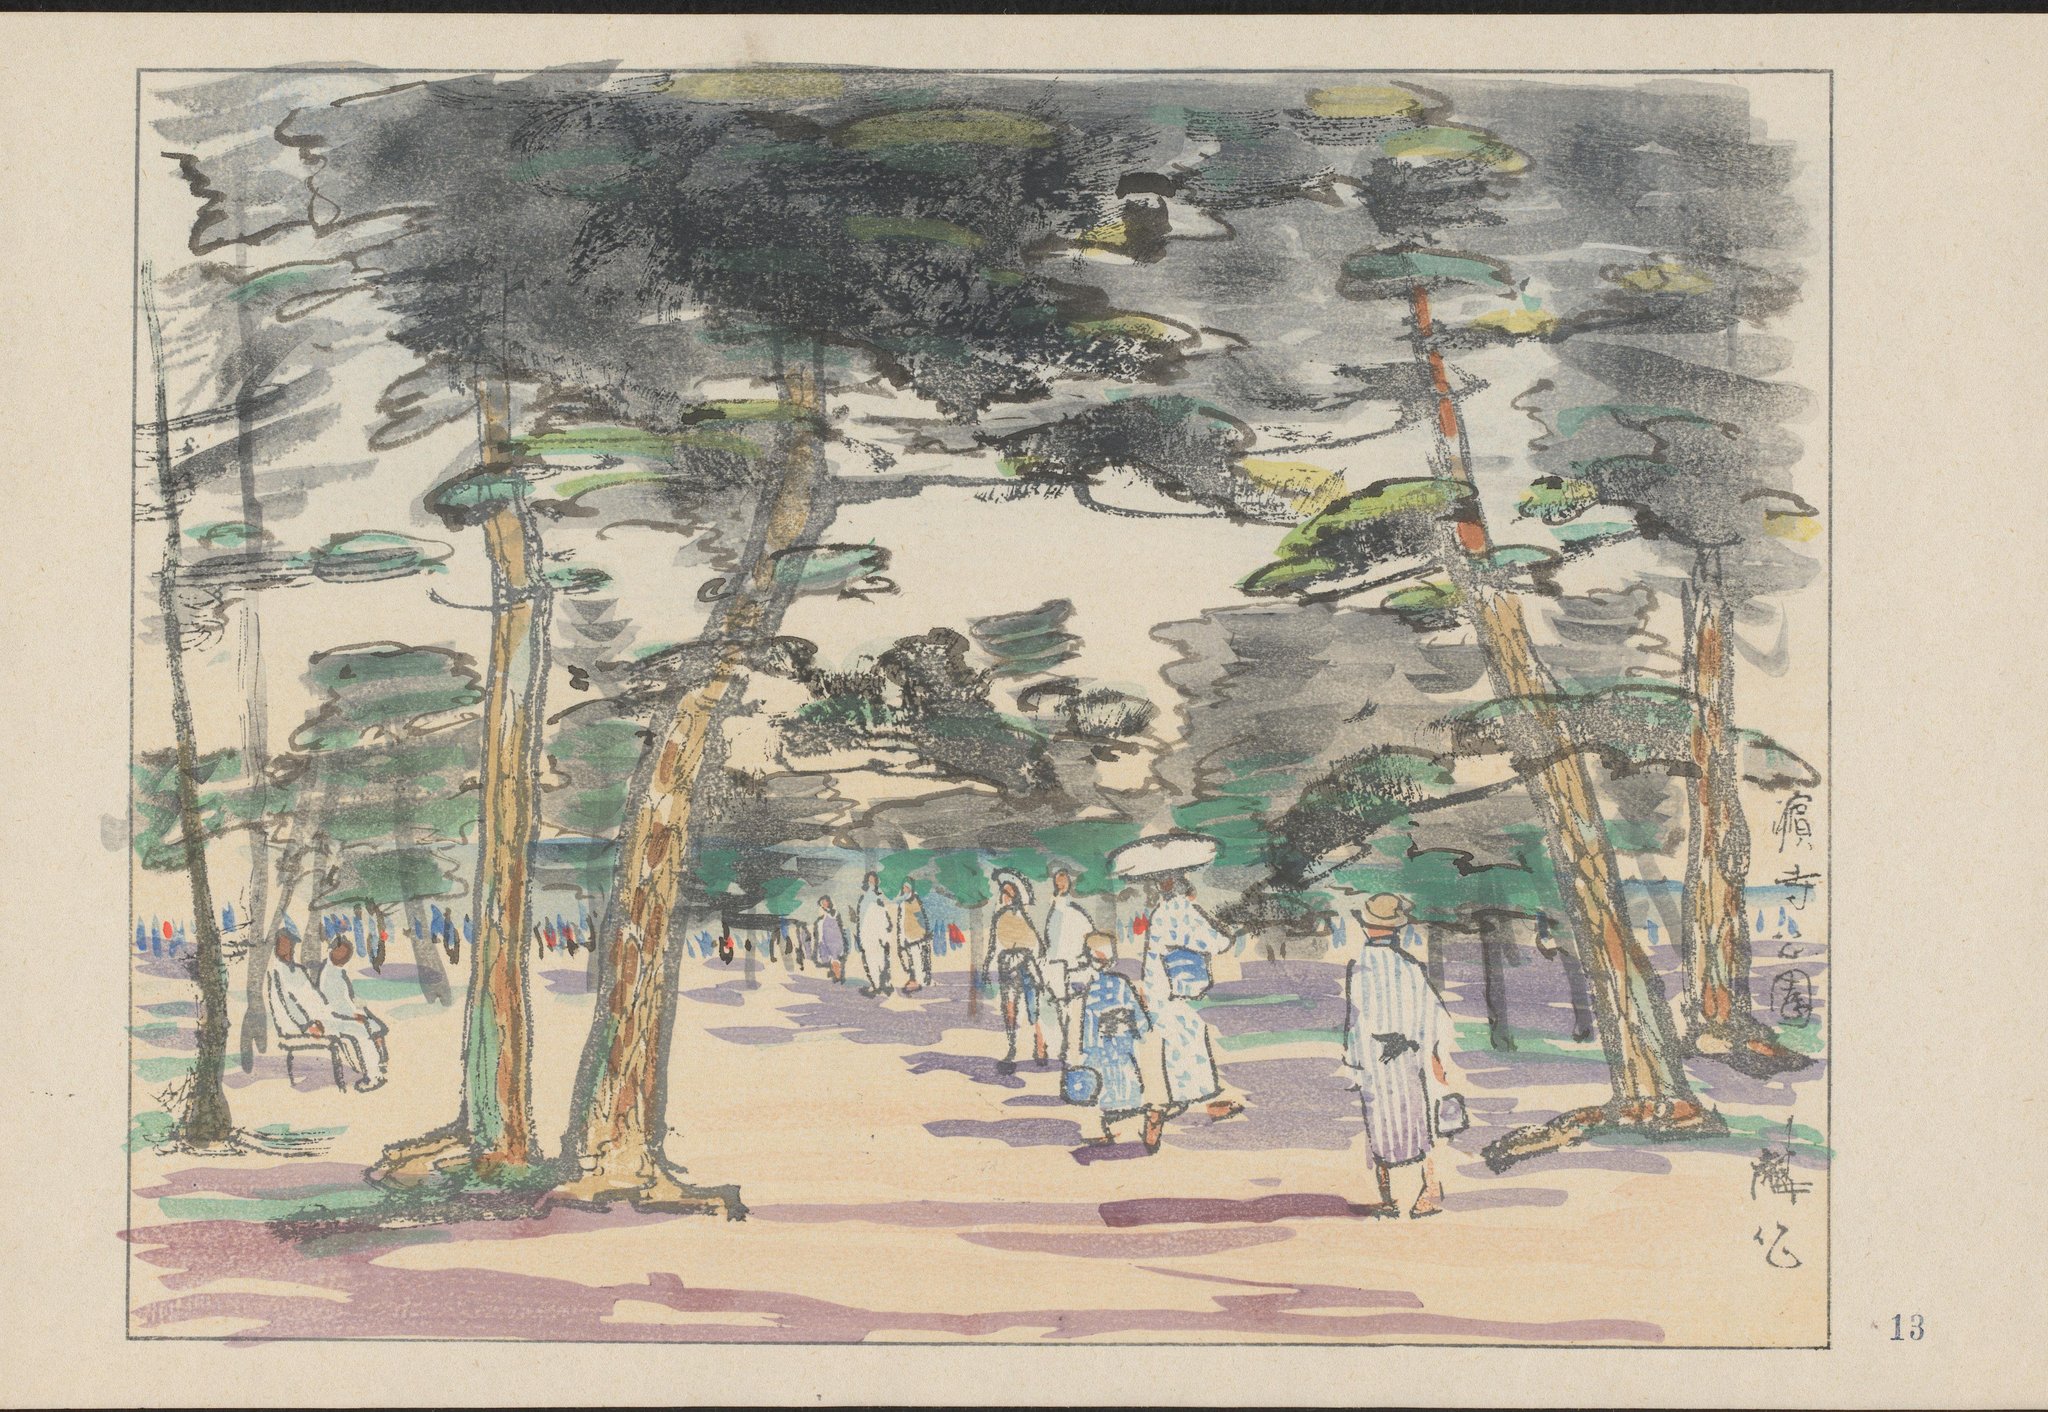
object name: print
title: Hamadera Park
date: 1947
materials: paper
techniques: woodcut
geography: japan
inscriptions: date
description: Mensen wandelen onder de pijnbomen in Hamadera park.